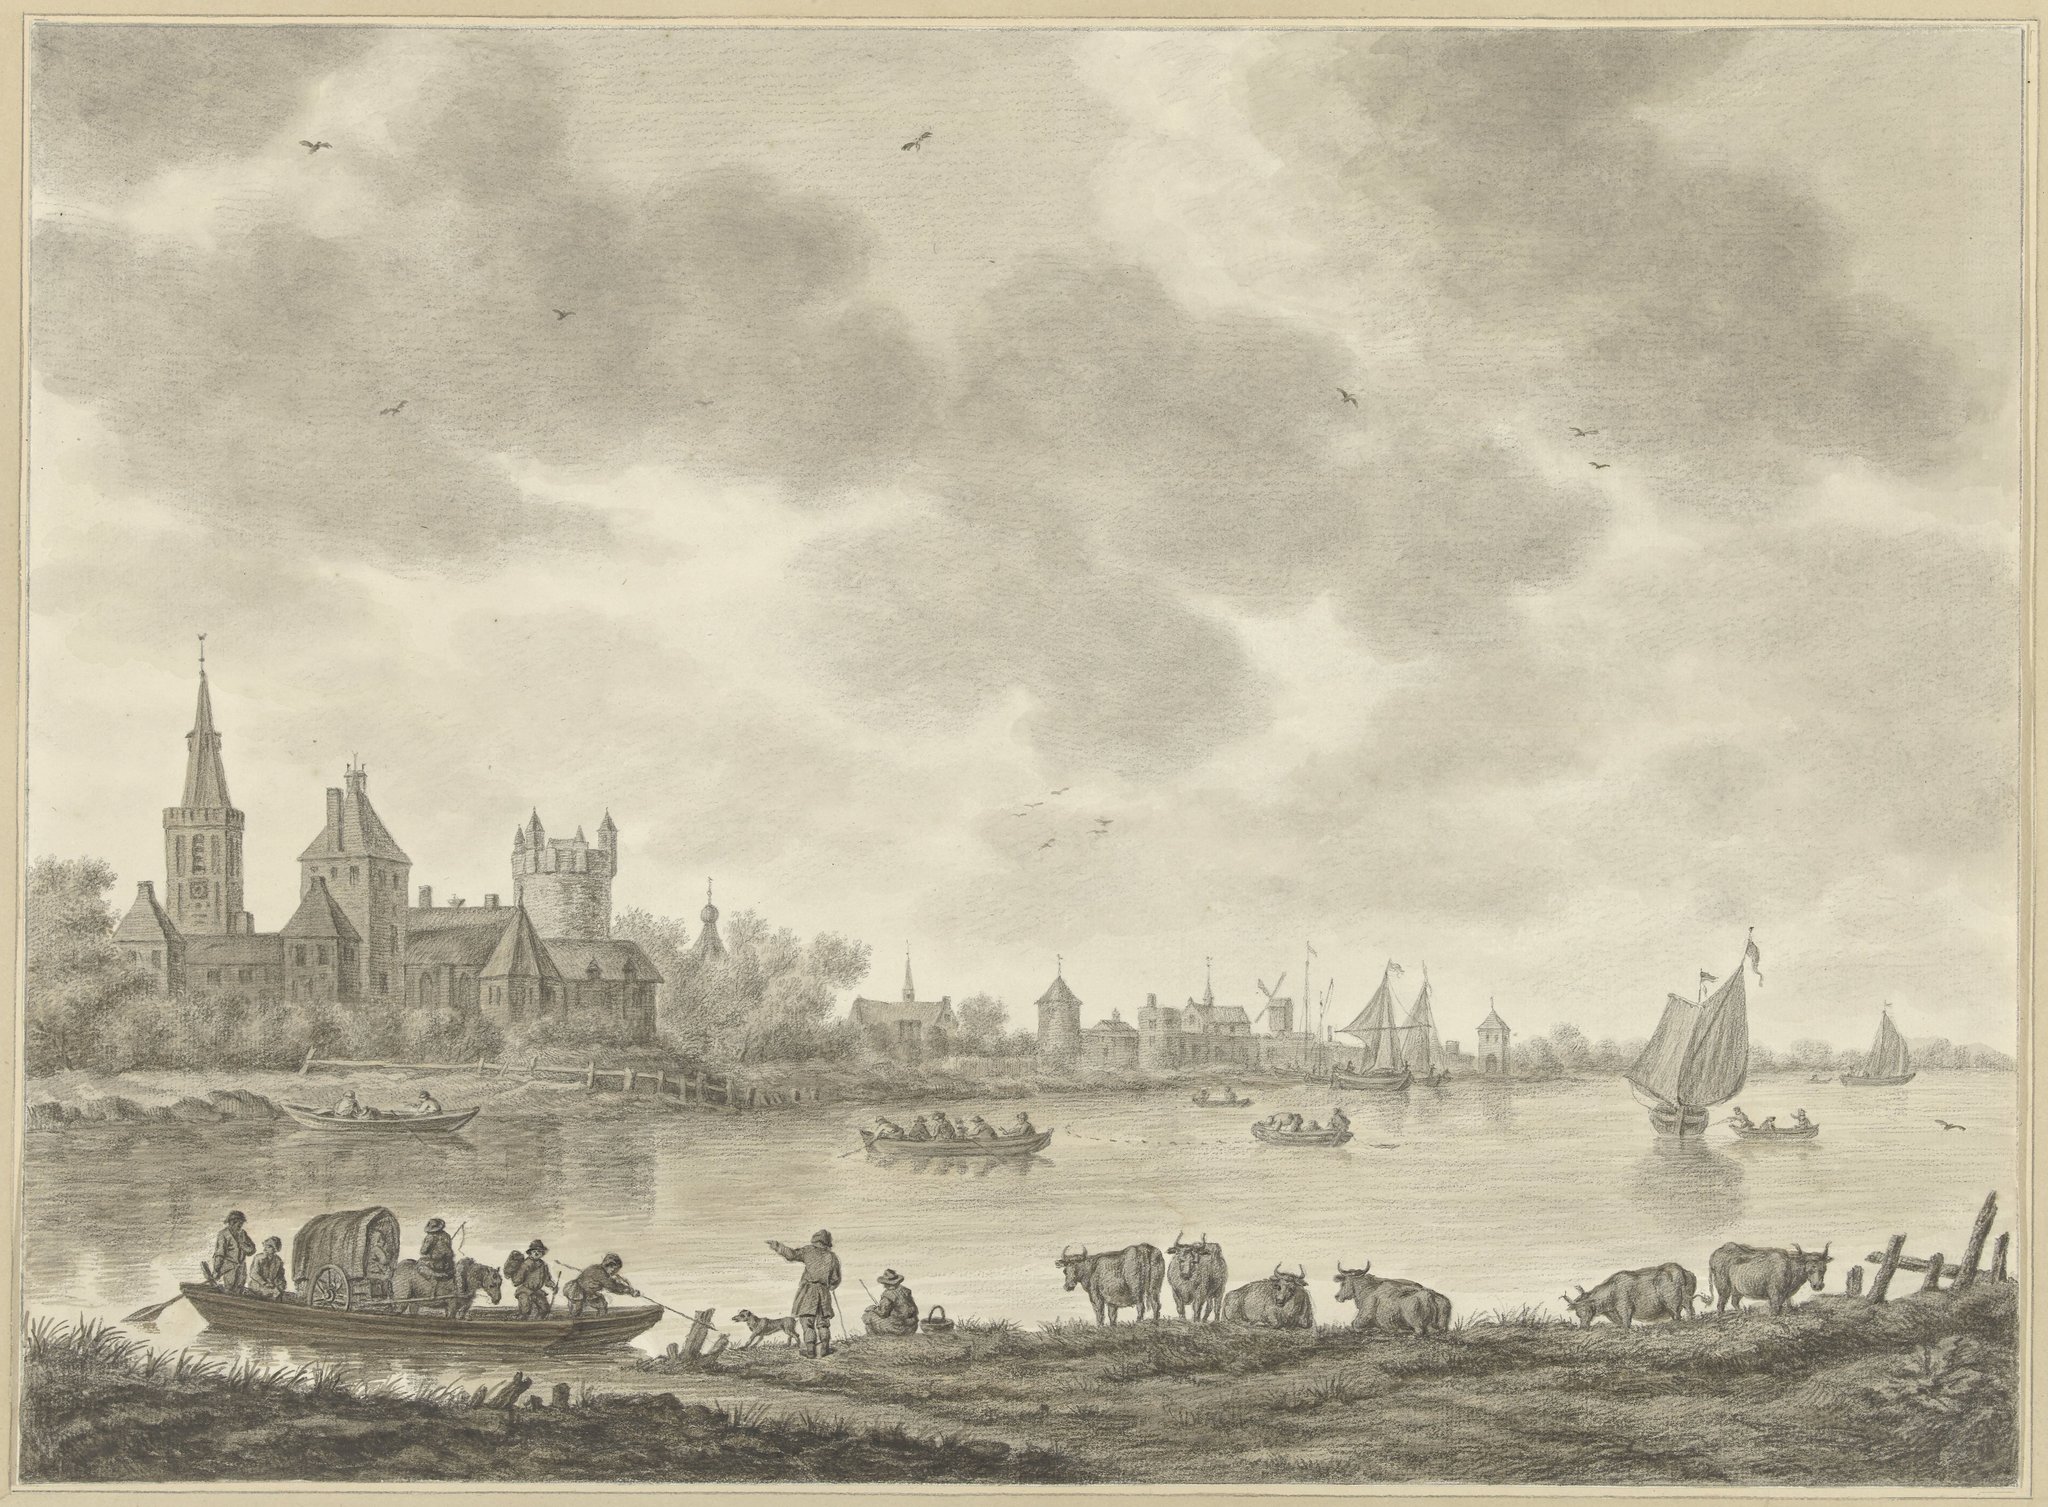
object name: drawing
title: Rivierlandschap met veer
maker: abraham delfos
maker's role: draughtsman, painter, print maker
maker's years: 1731-1820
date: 1741-1820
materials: chalk, paper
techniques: brush